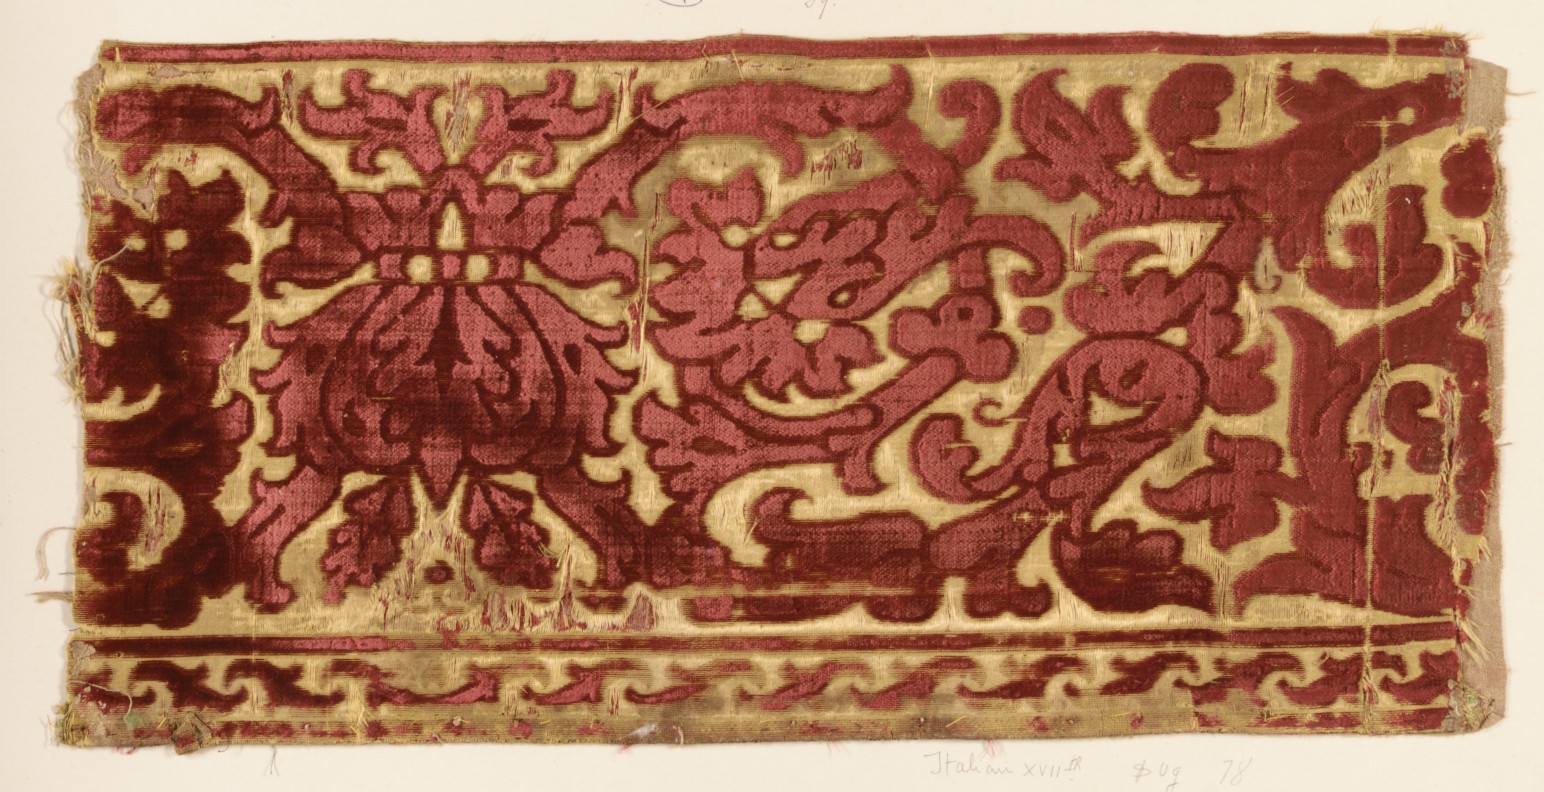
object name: fragment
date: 1601-1700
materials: silk